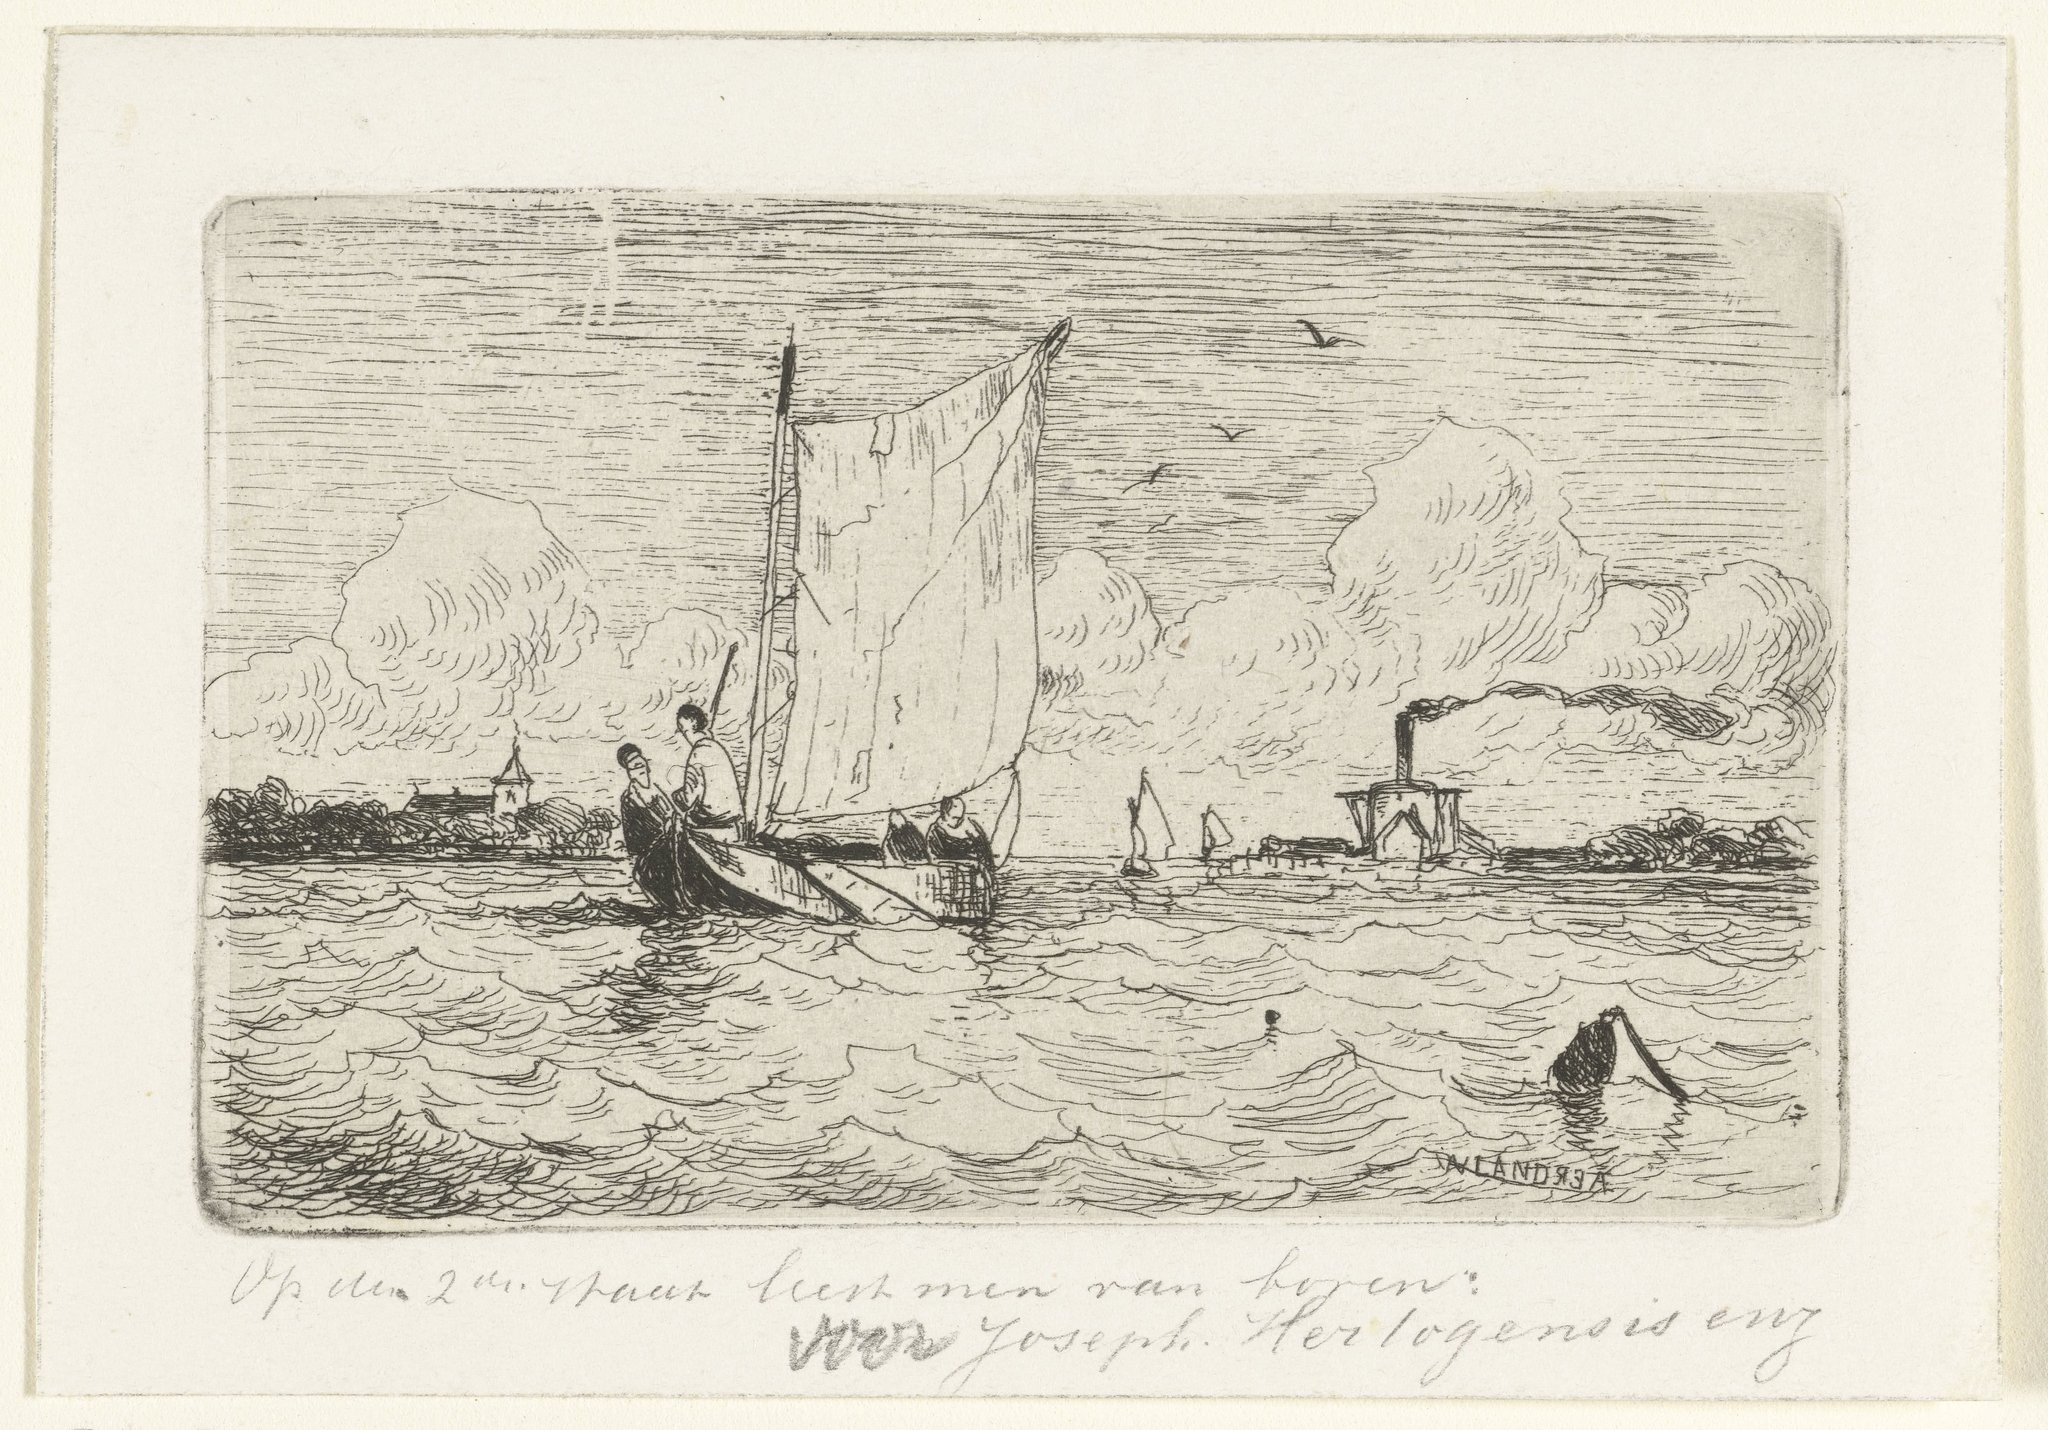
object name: print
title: Gezicht op de Haarlemmermeer met zeilschepen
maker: willem lodewijk andrea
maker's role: print maker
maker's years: 1817-1873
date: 1845-1852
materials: paper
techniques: etching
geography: netherlands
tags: lake, pumping installation, pumping-engine (~ polder)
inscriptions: collector's mark: Lugt 2228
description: Gezicht op de Haarlemmermeer met zeilschepen, links op de achtergrond een dorp, rechts een van de stoomgemalen.